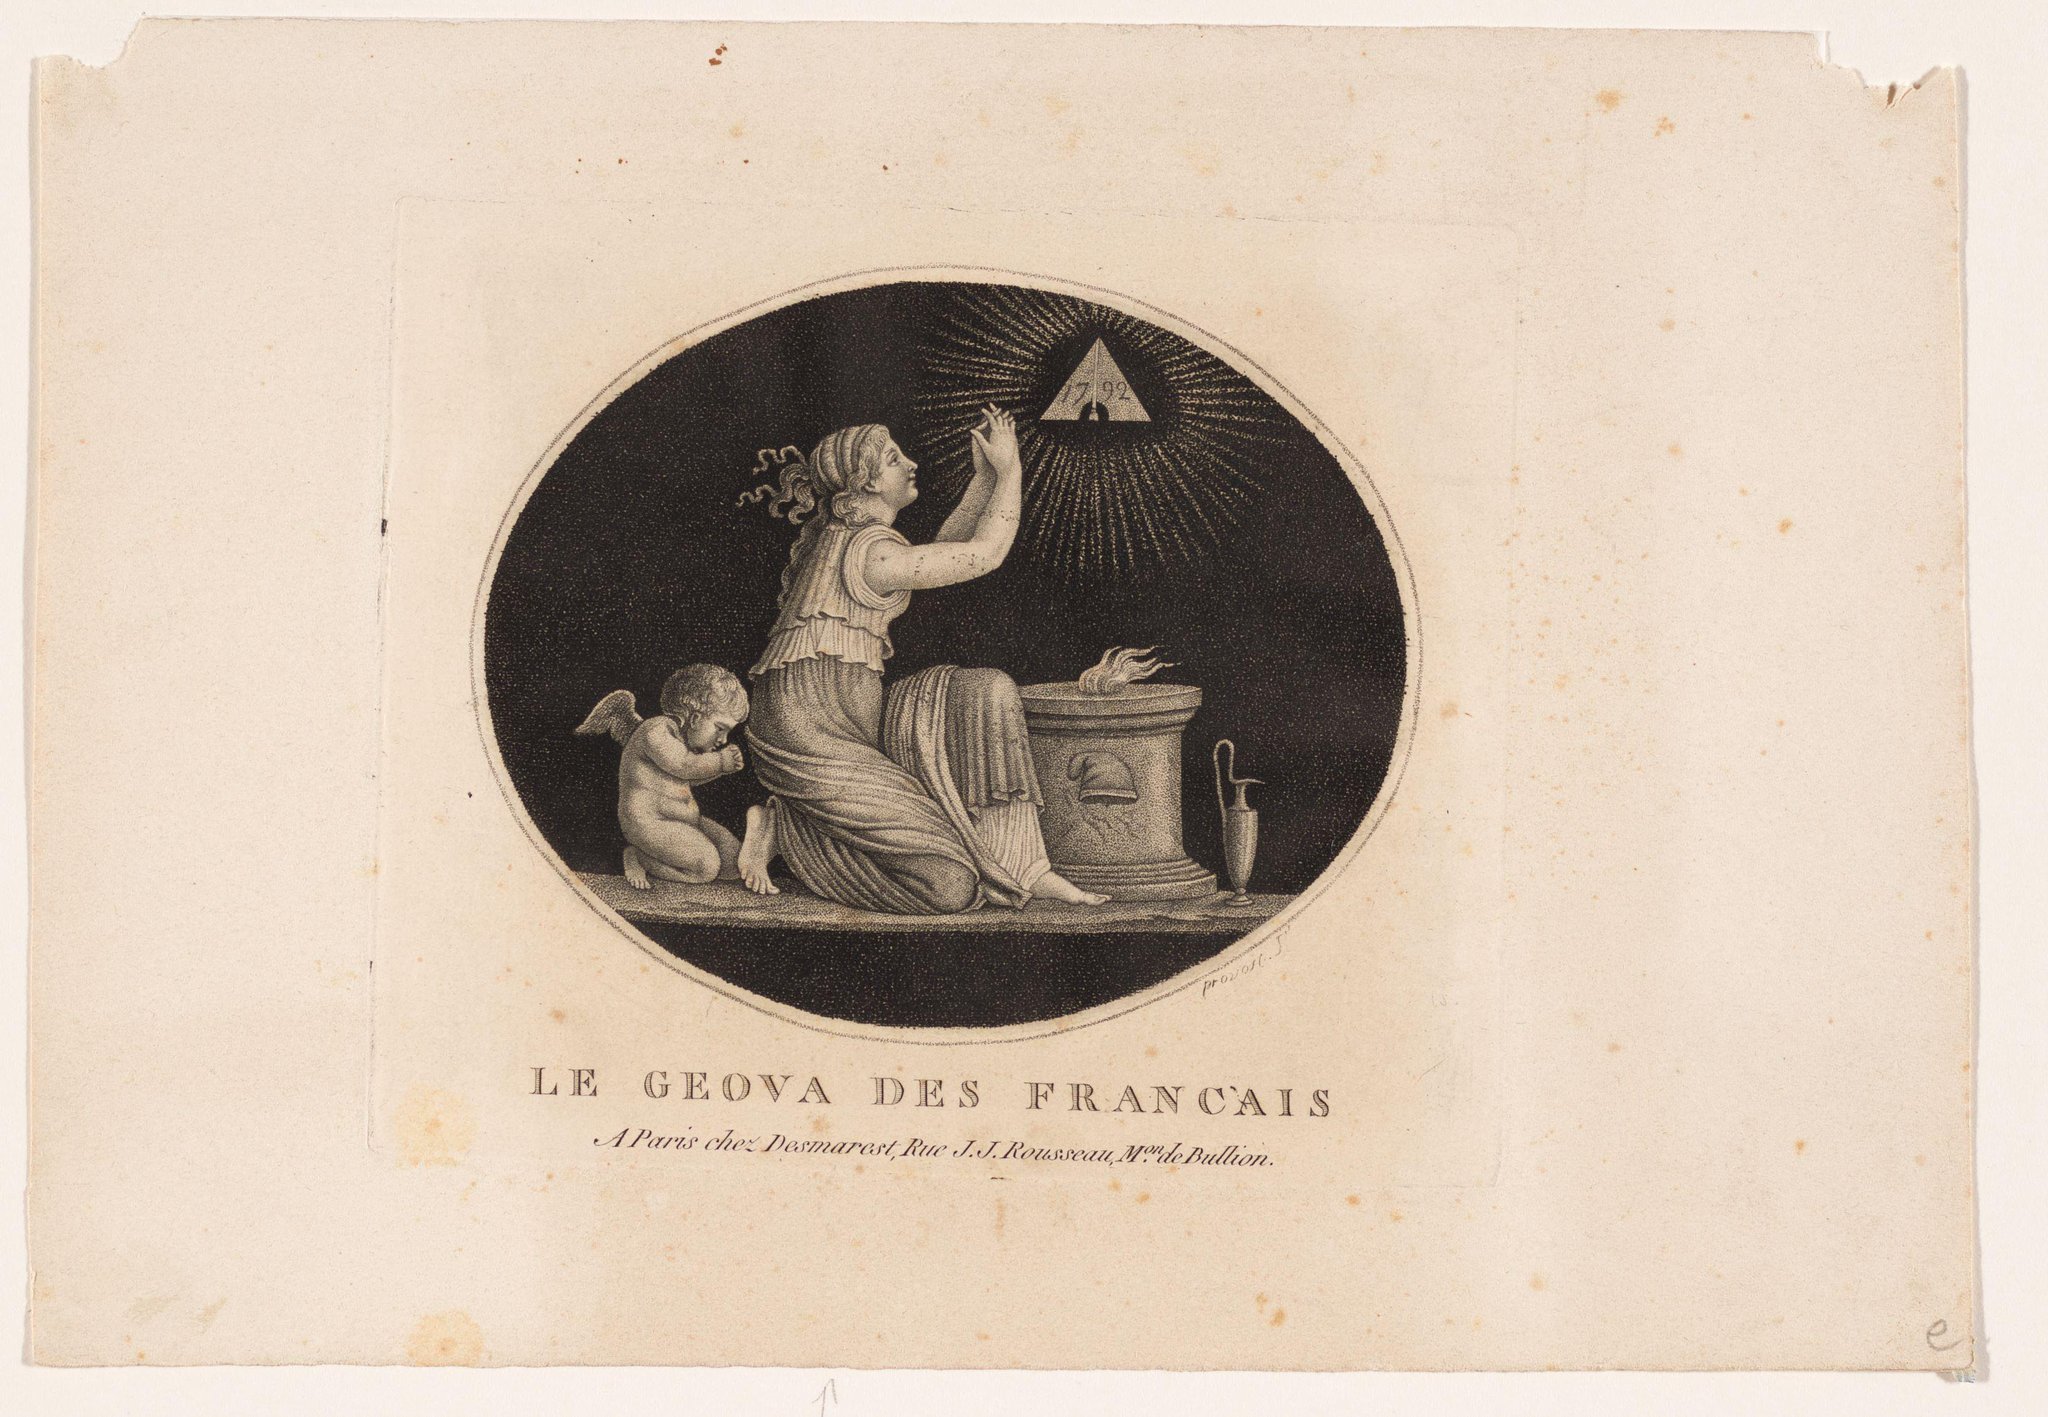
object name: print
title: Figures et emblèmes allégoriques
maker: desmarest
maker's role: publisher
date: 1792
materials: paper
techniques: engraving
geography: paris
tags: movements derived from protestant churches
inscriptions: collector's mark: Lugt 2228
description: Personificatie van de Franse staat en een putto in aanbidding voor een driehoek met het jaartal 1792.